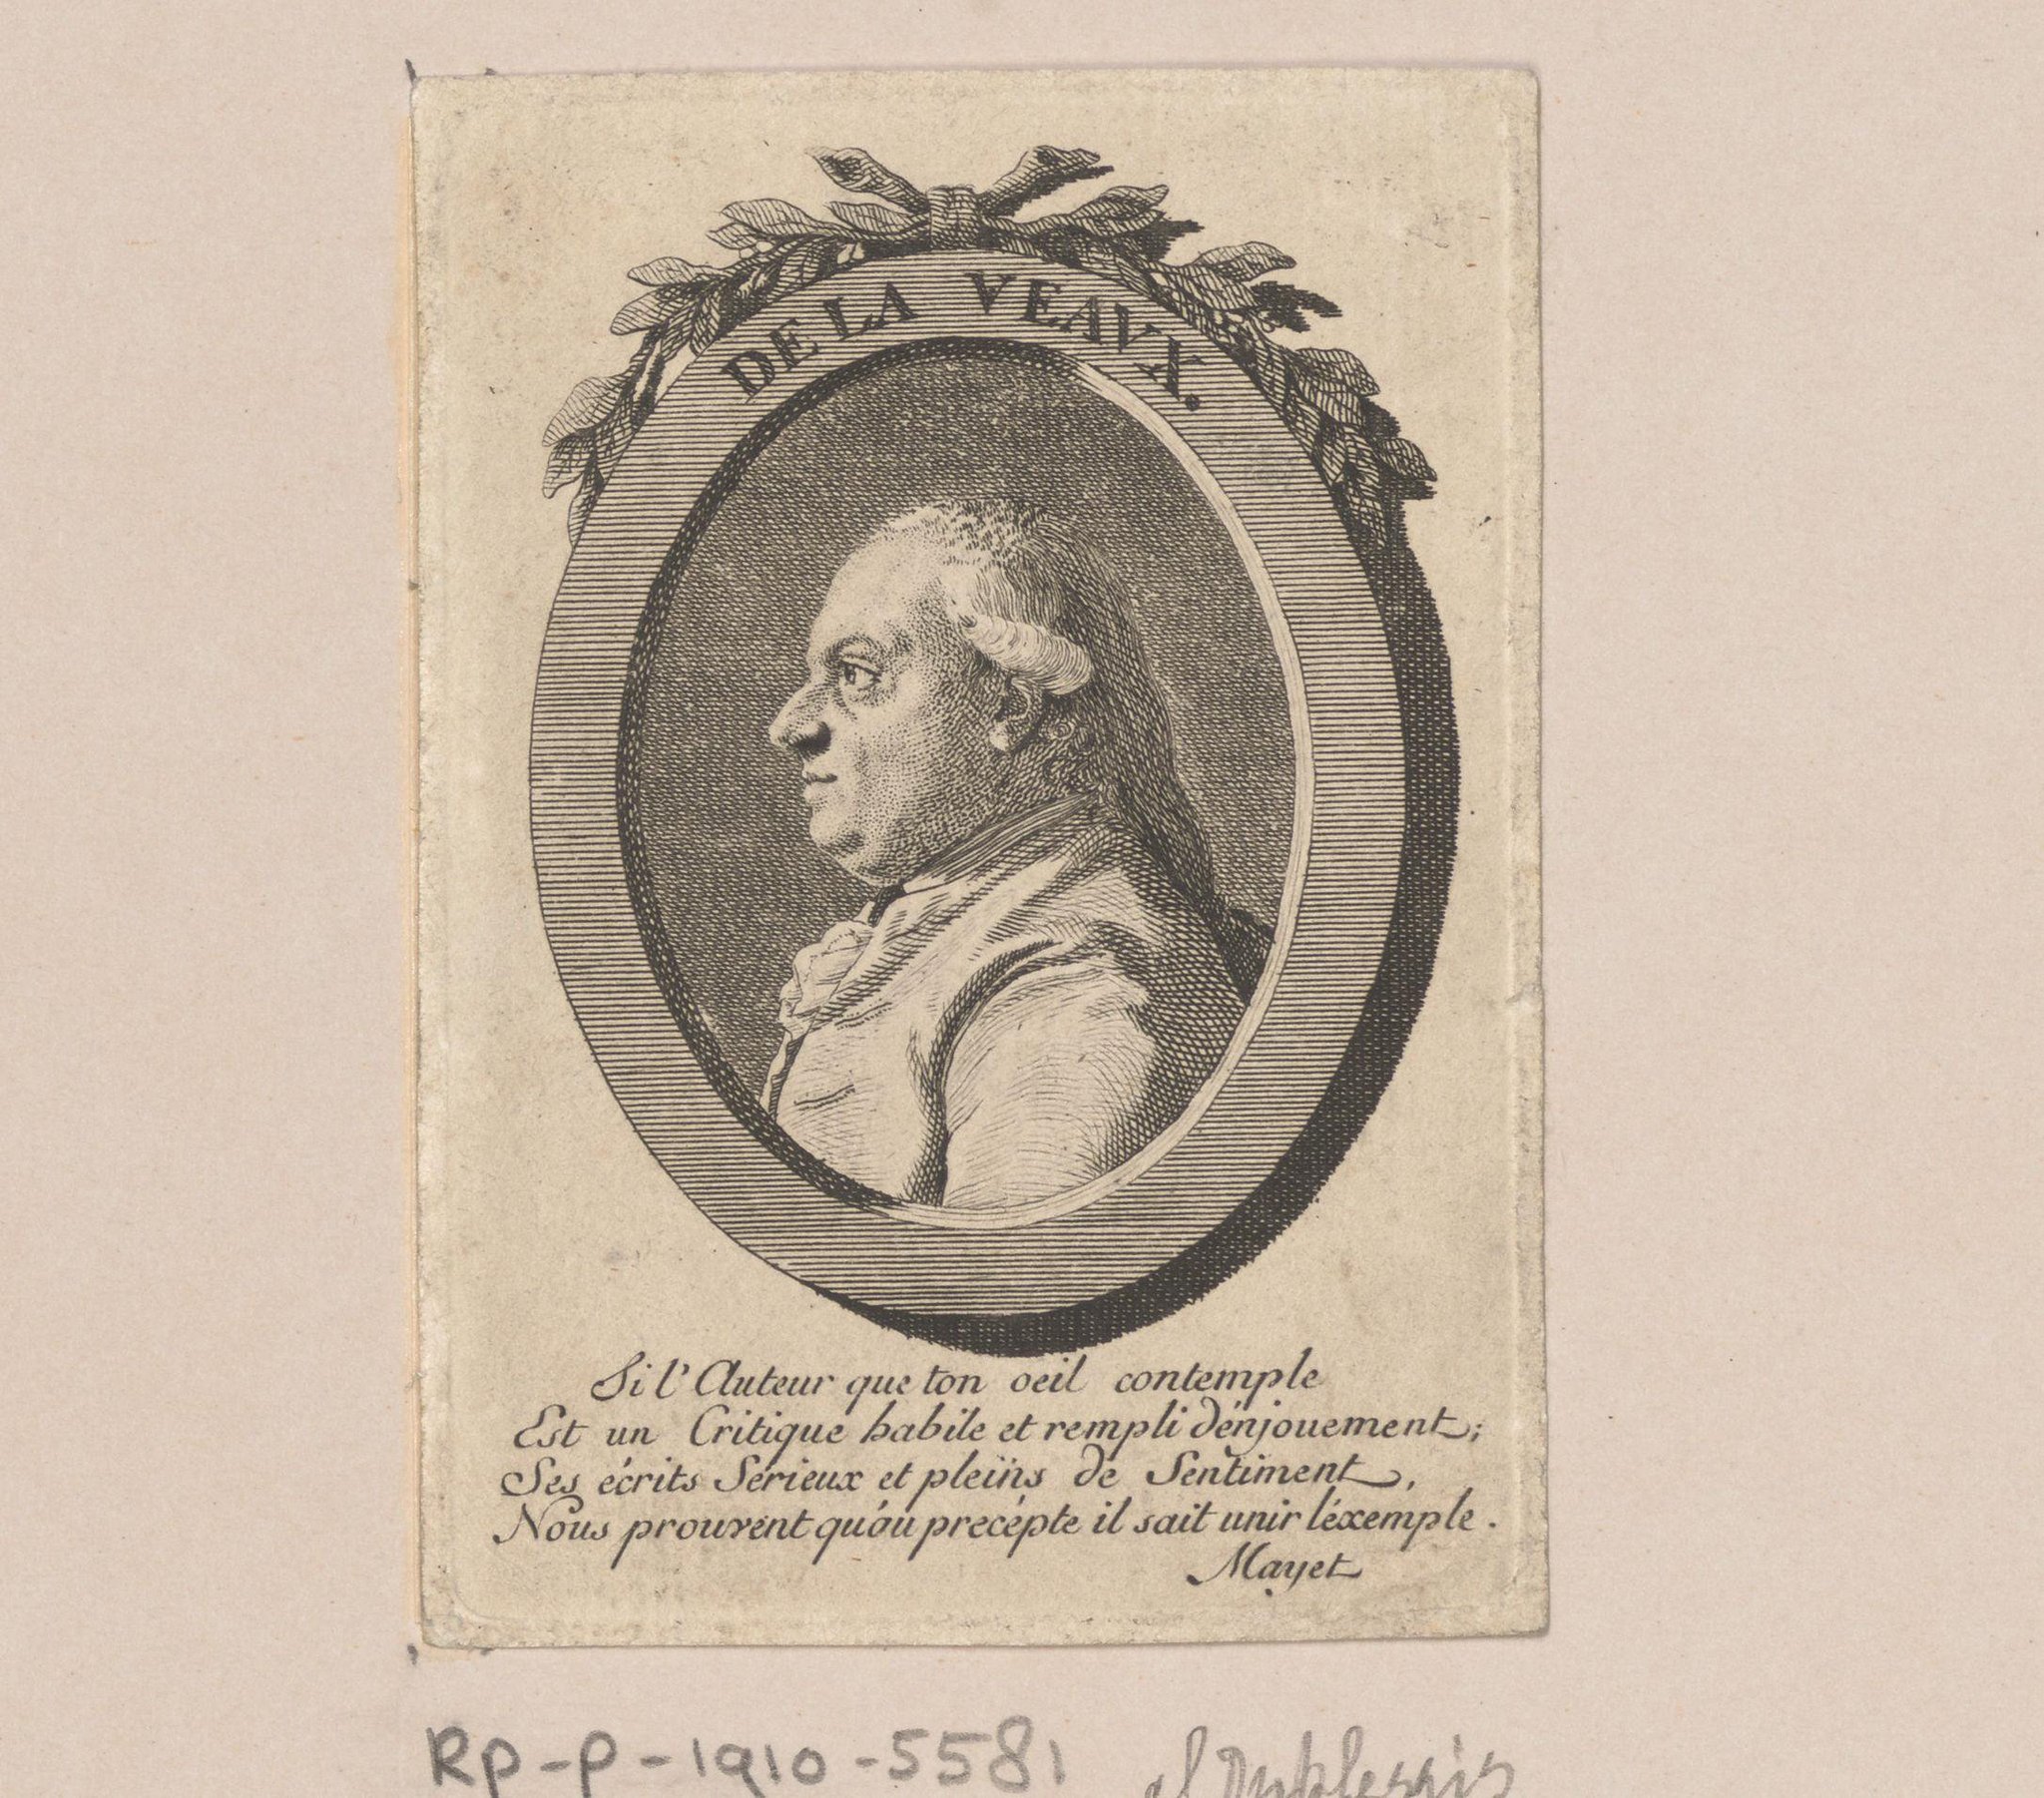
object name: print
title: Portret van Jean-Charles Laveaux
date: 1790-1830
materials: paper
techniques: etching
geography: france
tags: paris, ornament ~ medallion, historical persons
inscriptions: signature: ‘Mayet’, collector's mark: Lugt 2228